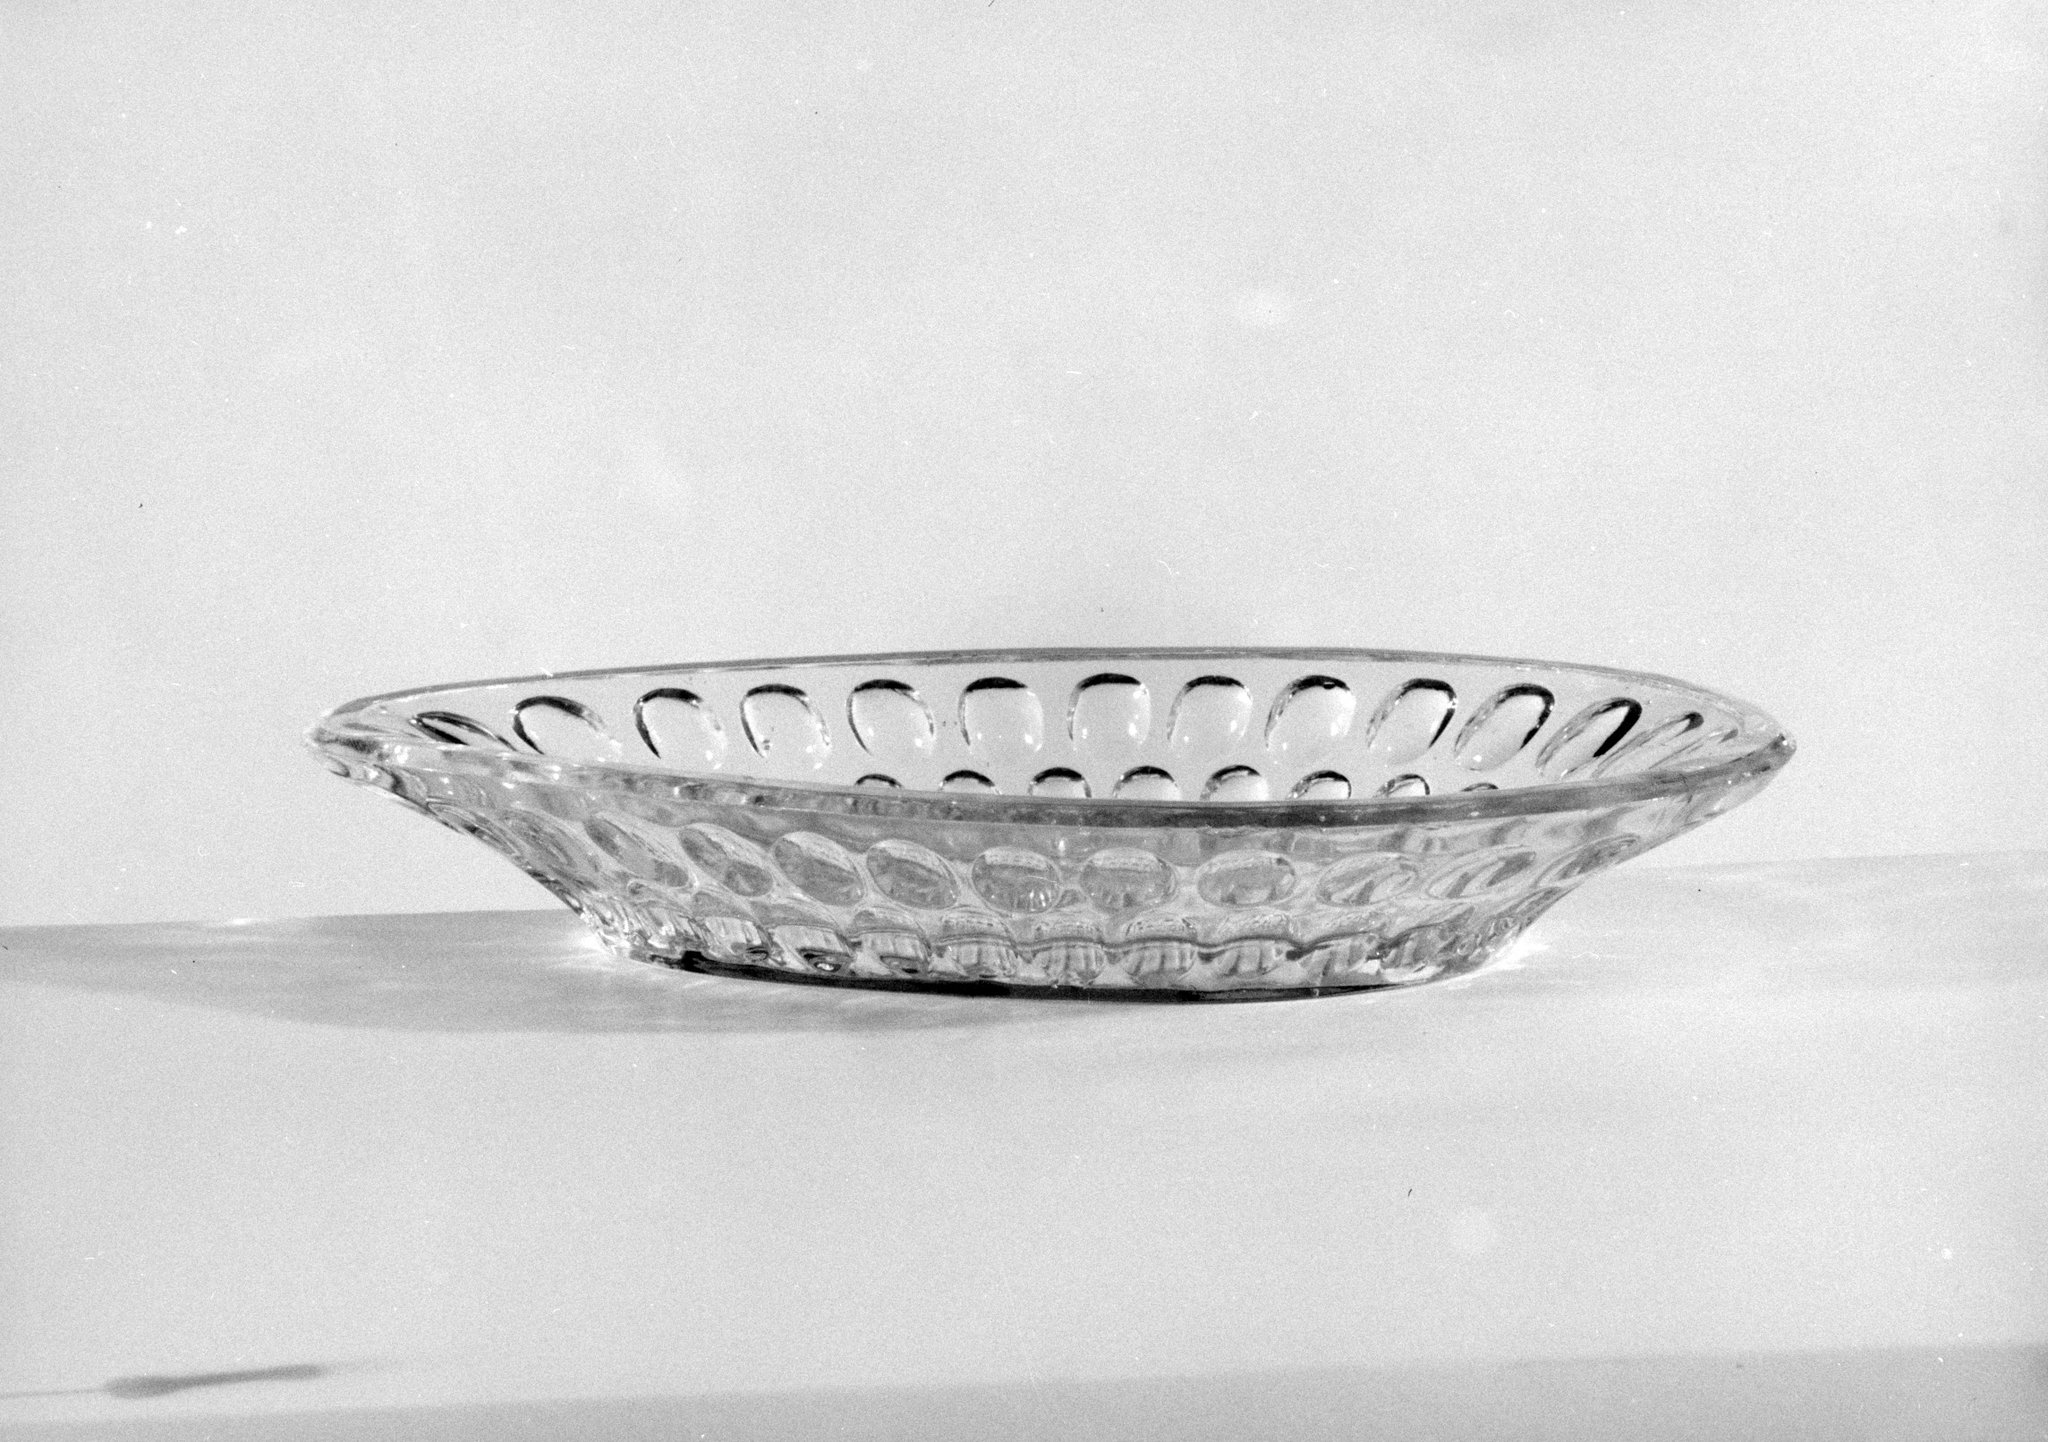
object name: pickle dish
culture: american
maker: bakewell, pears and company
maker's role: maker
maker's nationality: american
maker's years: 1836-1882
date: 1850-1870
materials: glass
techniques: pressed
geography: united states